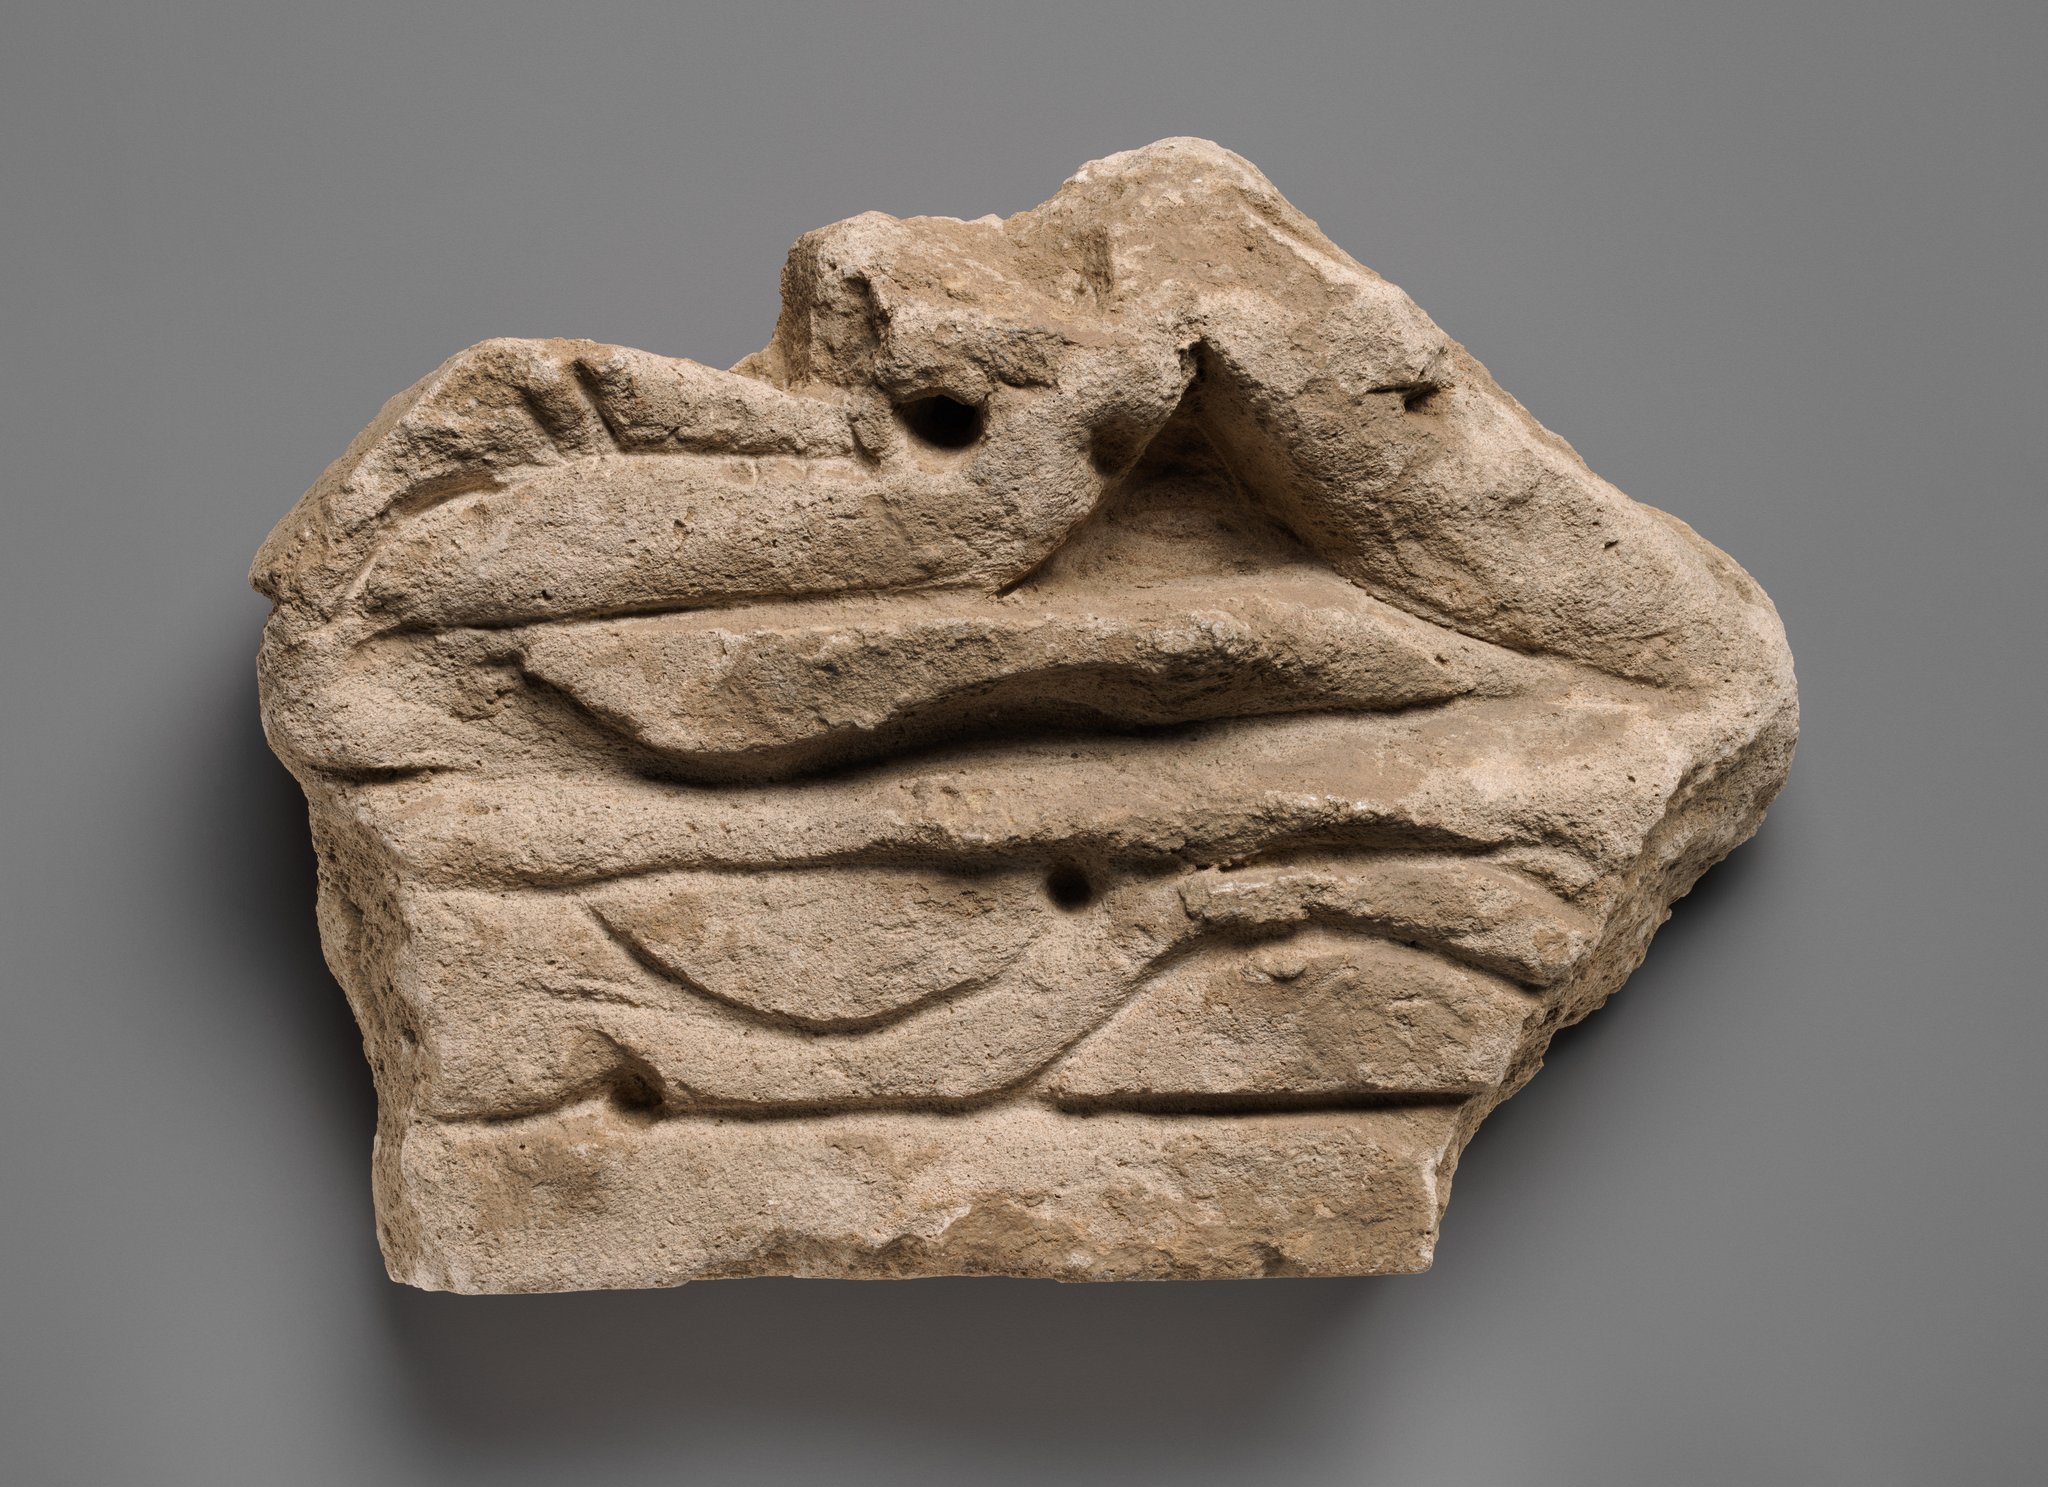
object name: relief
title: Relief fragment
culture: sasanian or islamic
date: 501-800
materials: plaster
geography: mesopotamia